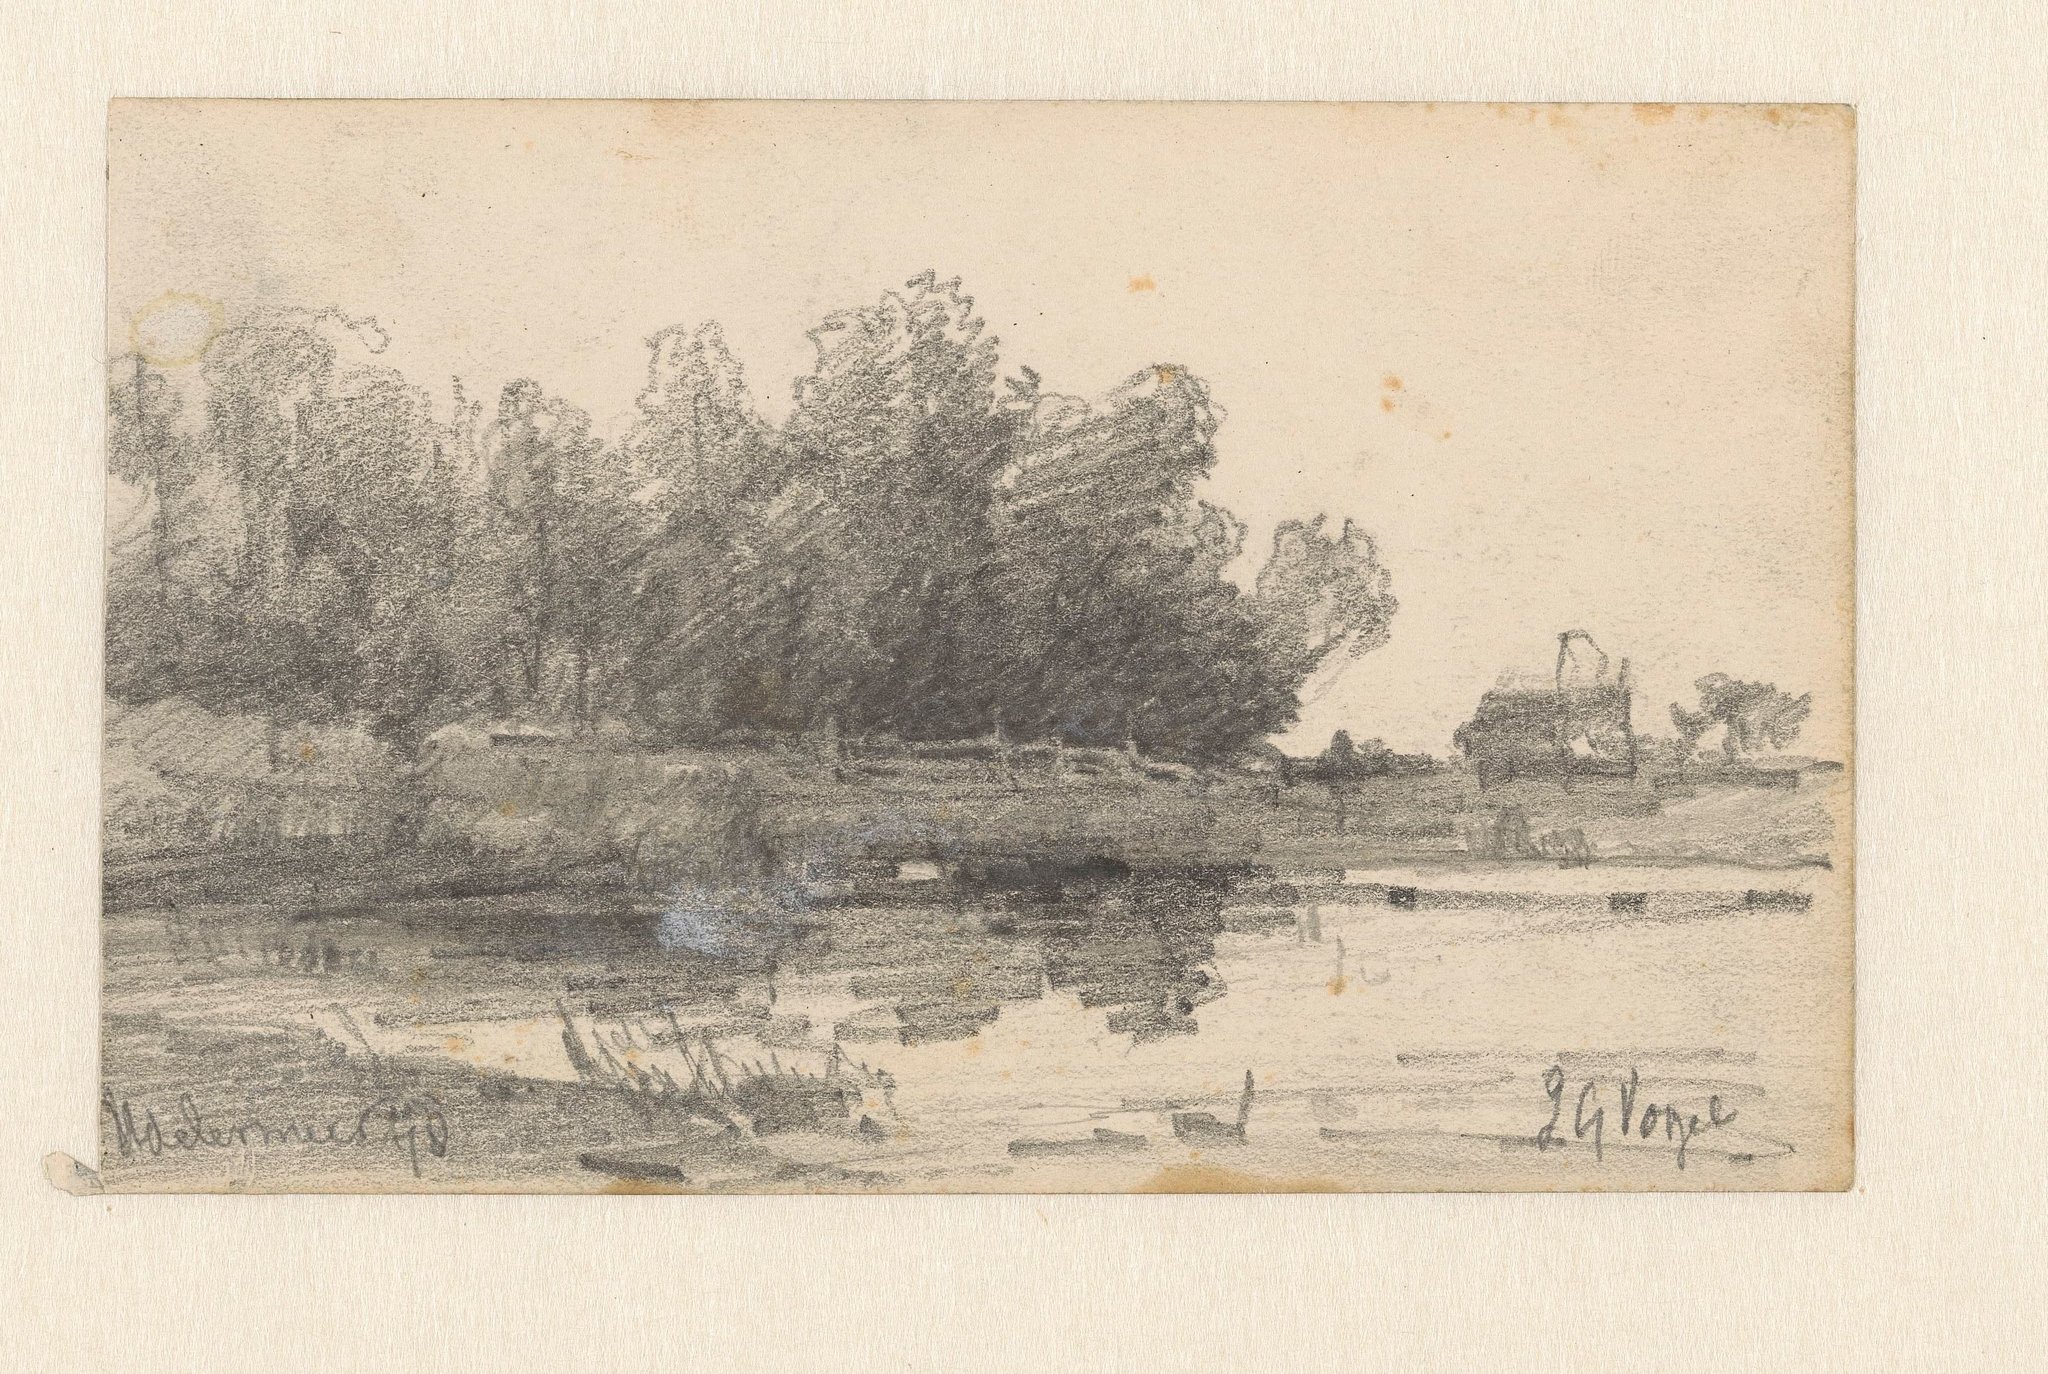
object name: drawing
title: Gezicht op het Uddelermeer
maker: johannes gijsbert vogel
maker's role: draughtsman, painter, print maker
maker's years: 1828-1915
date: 1878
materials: chalk, paper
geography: uddel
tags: lake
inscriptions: date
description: Gezicht op het Uddelermeer; verso: Scheveningse bosjes, nov. 1879.